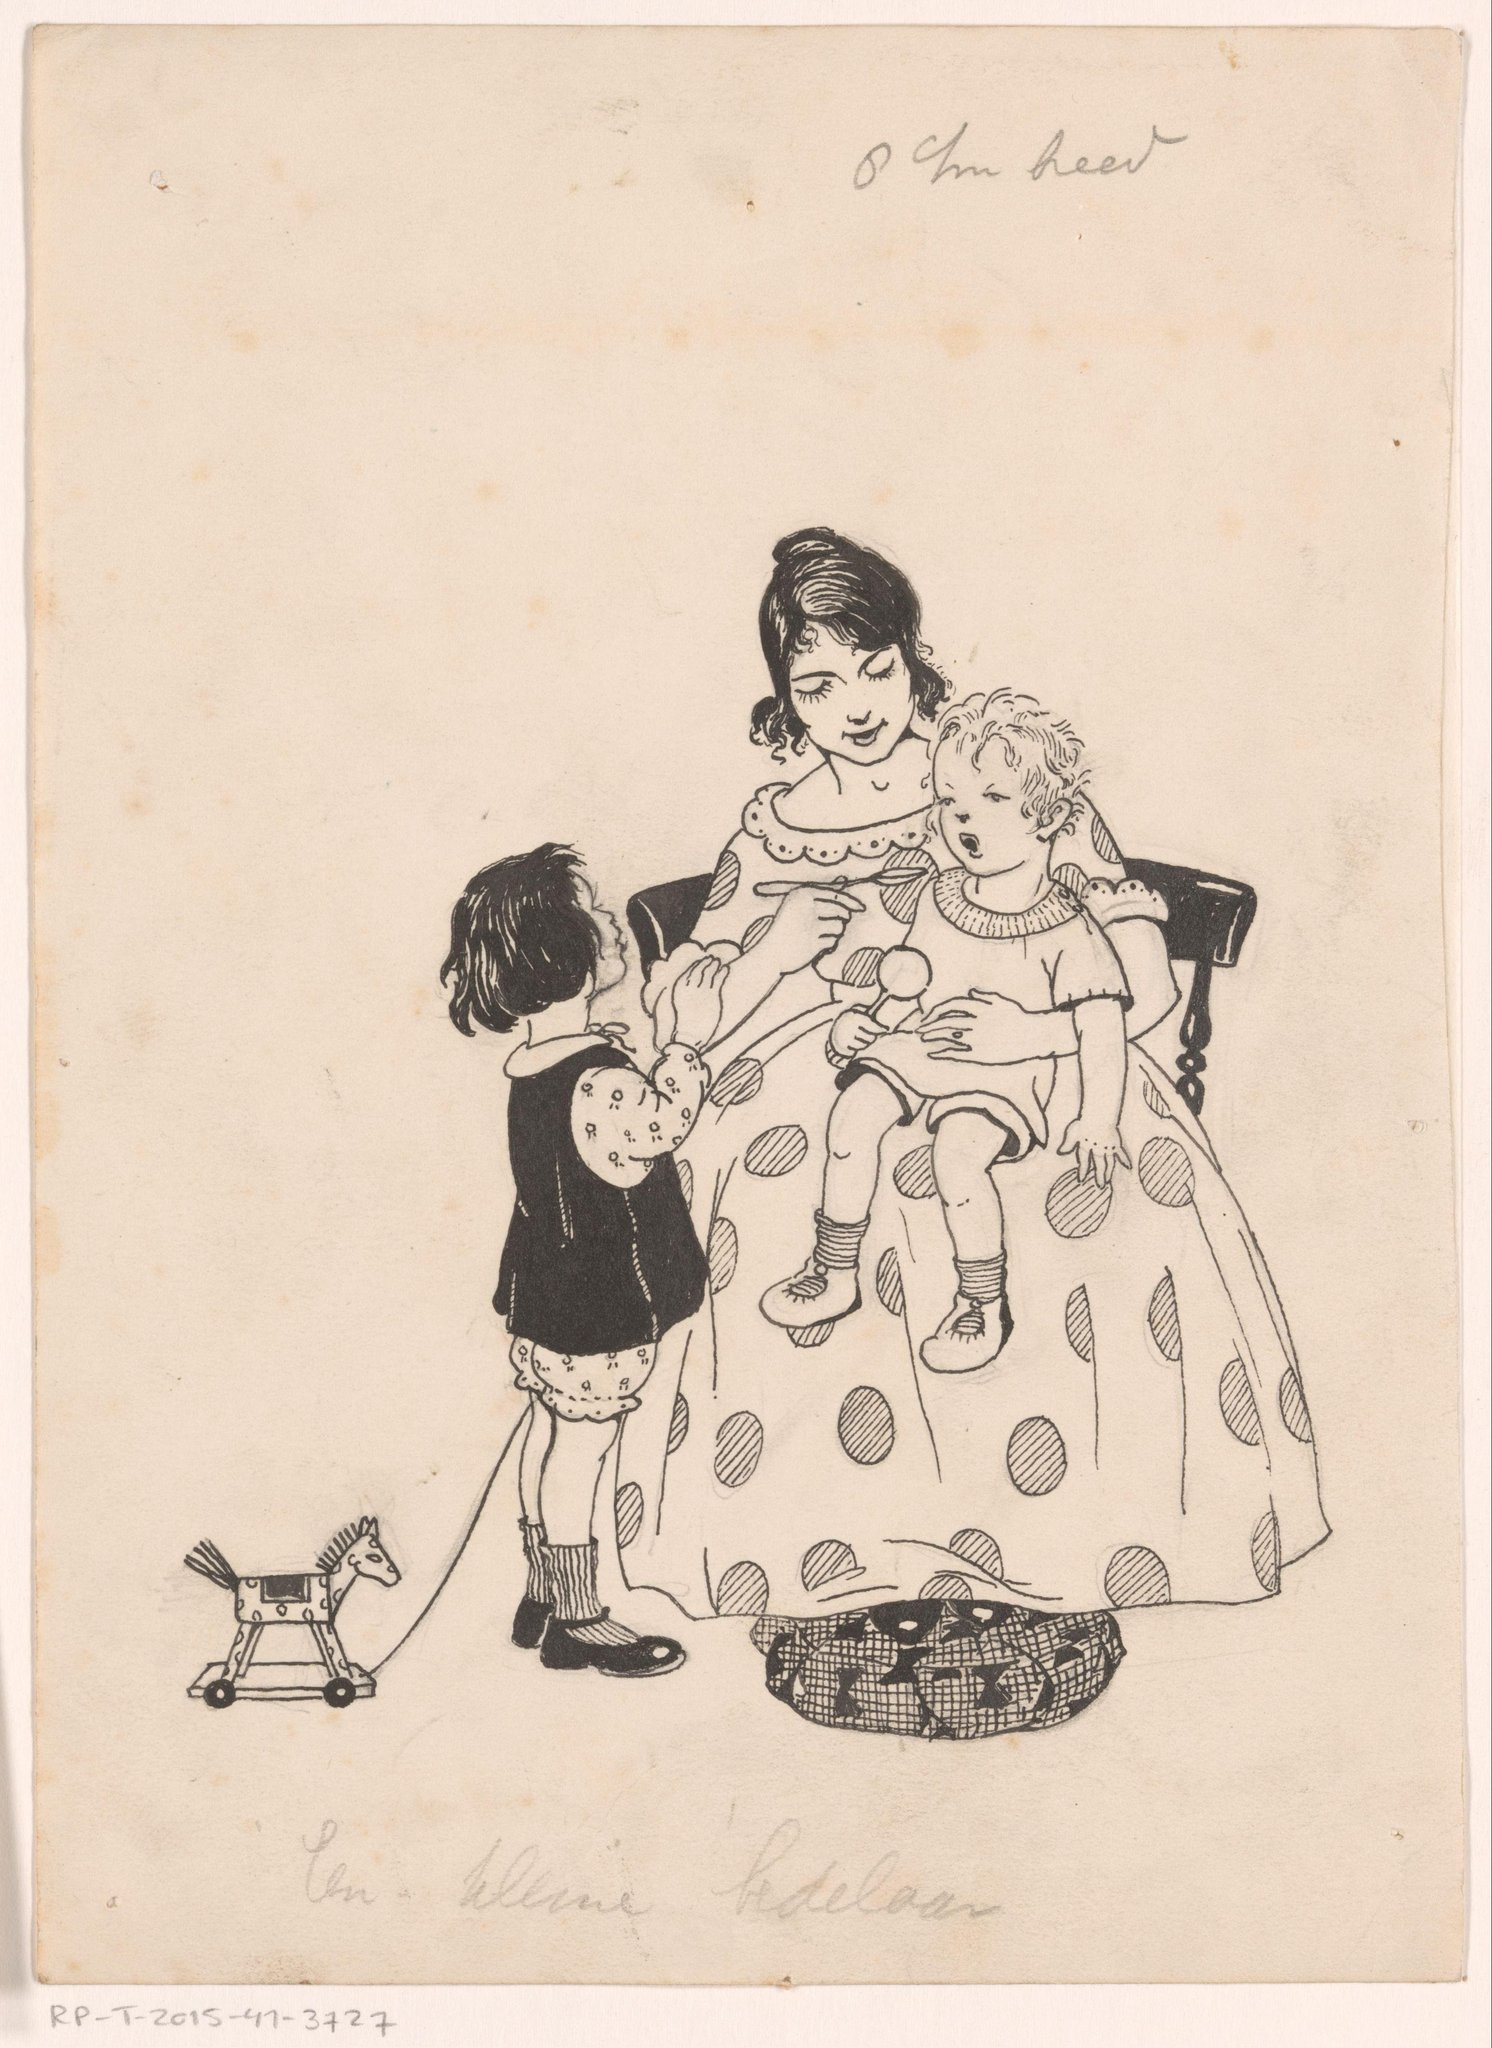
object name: boekillustratie ontwerp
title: Moeder voert een kind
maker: Anonymous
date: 1880-1920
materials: ink, paper, pencil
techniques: pen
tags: feeding a baby, mother and child(ren), woman and child(ren) (family group)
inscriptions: collector's mark: Lugt 2228a, annotation: ‘Een kleine bedelaar’, :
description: Een moeder zit op een stoel met een kind op schoot. Ze voert het kind met een lepel. Naast haar staat een meisje met een trekpaard toe te kijken.